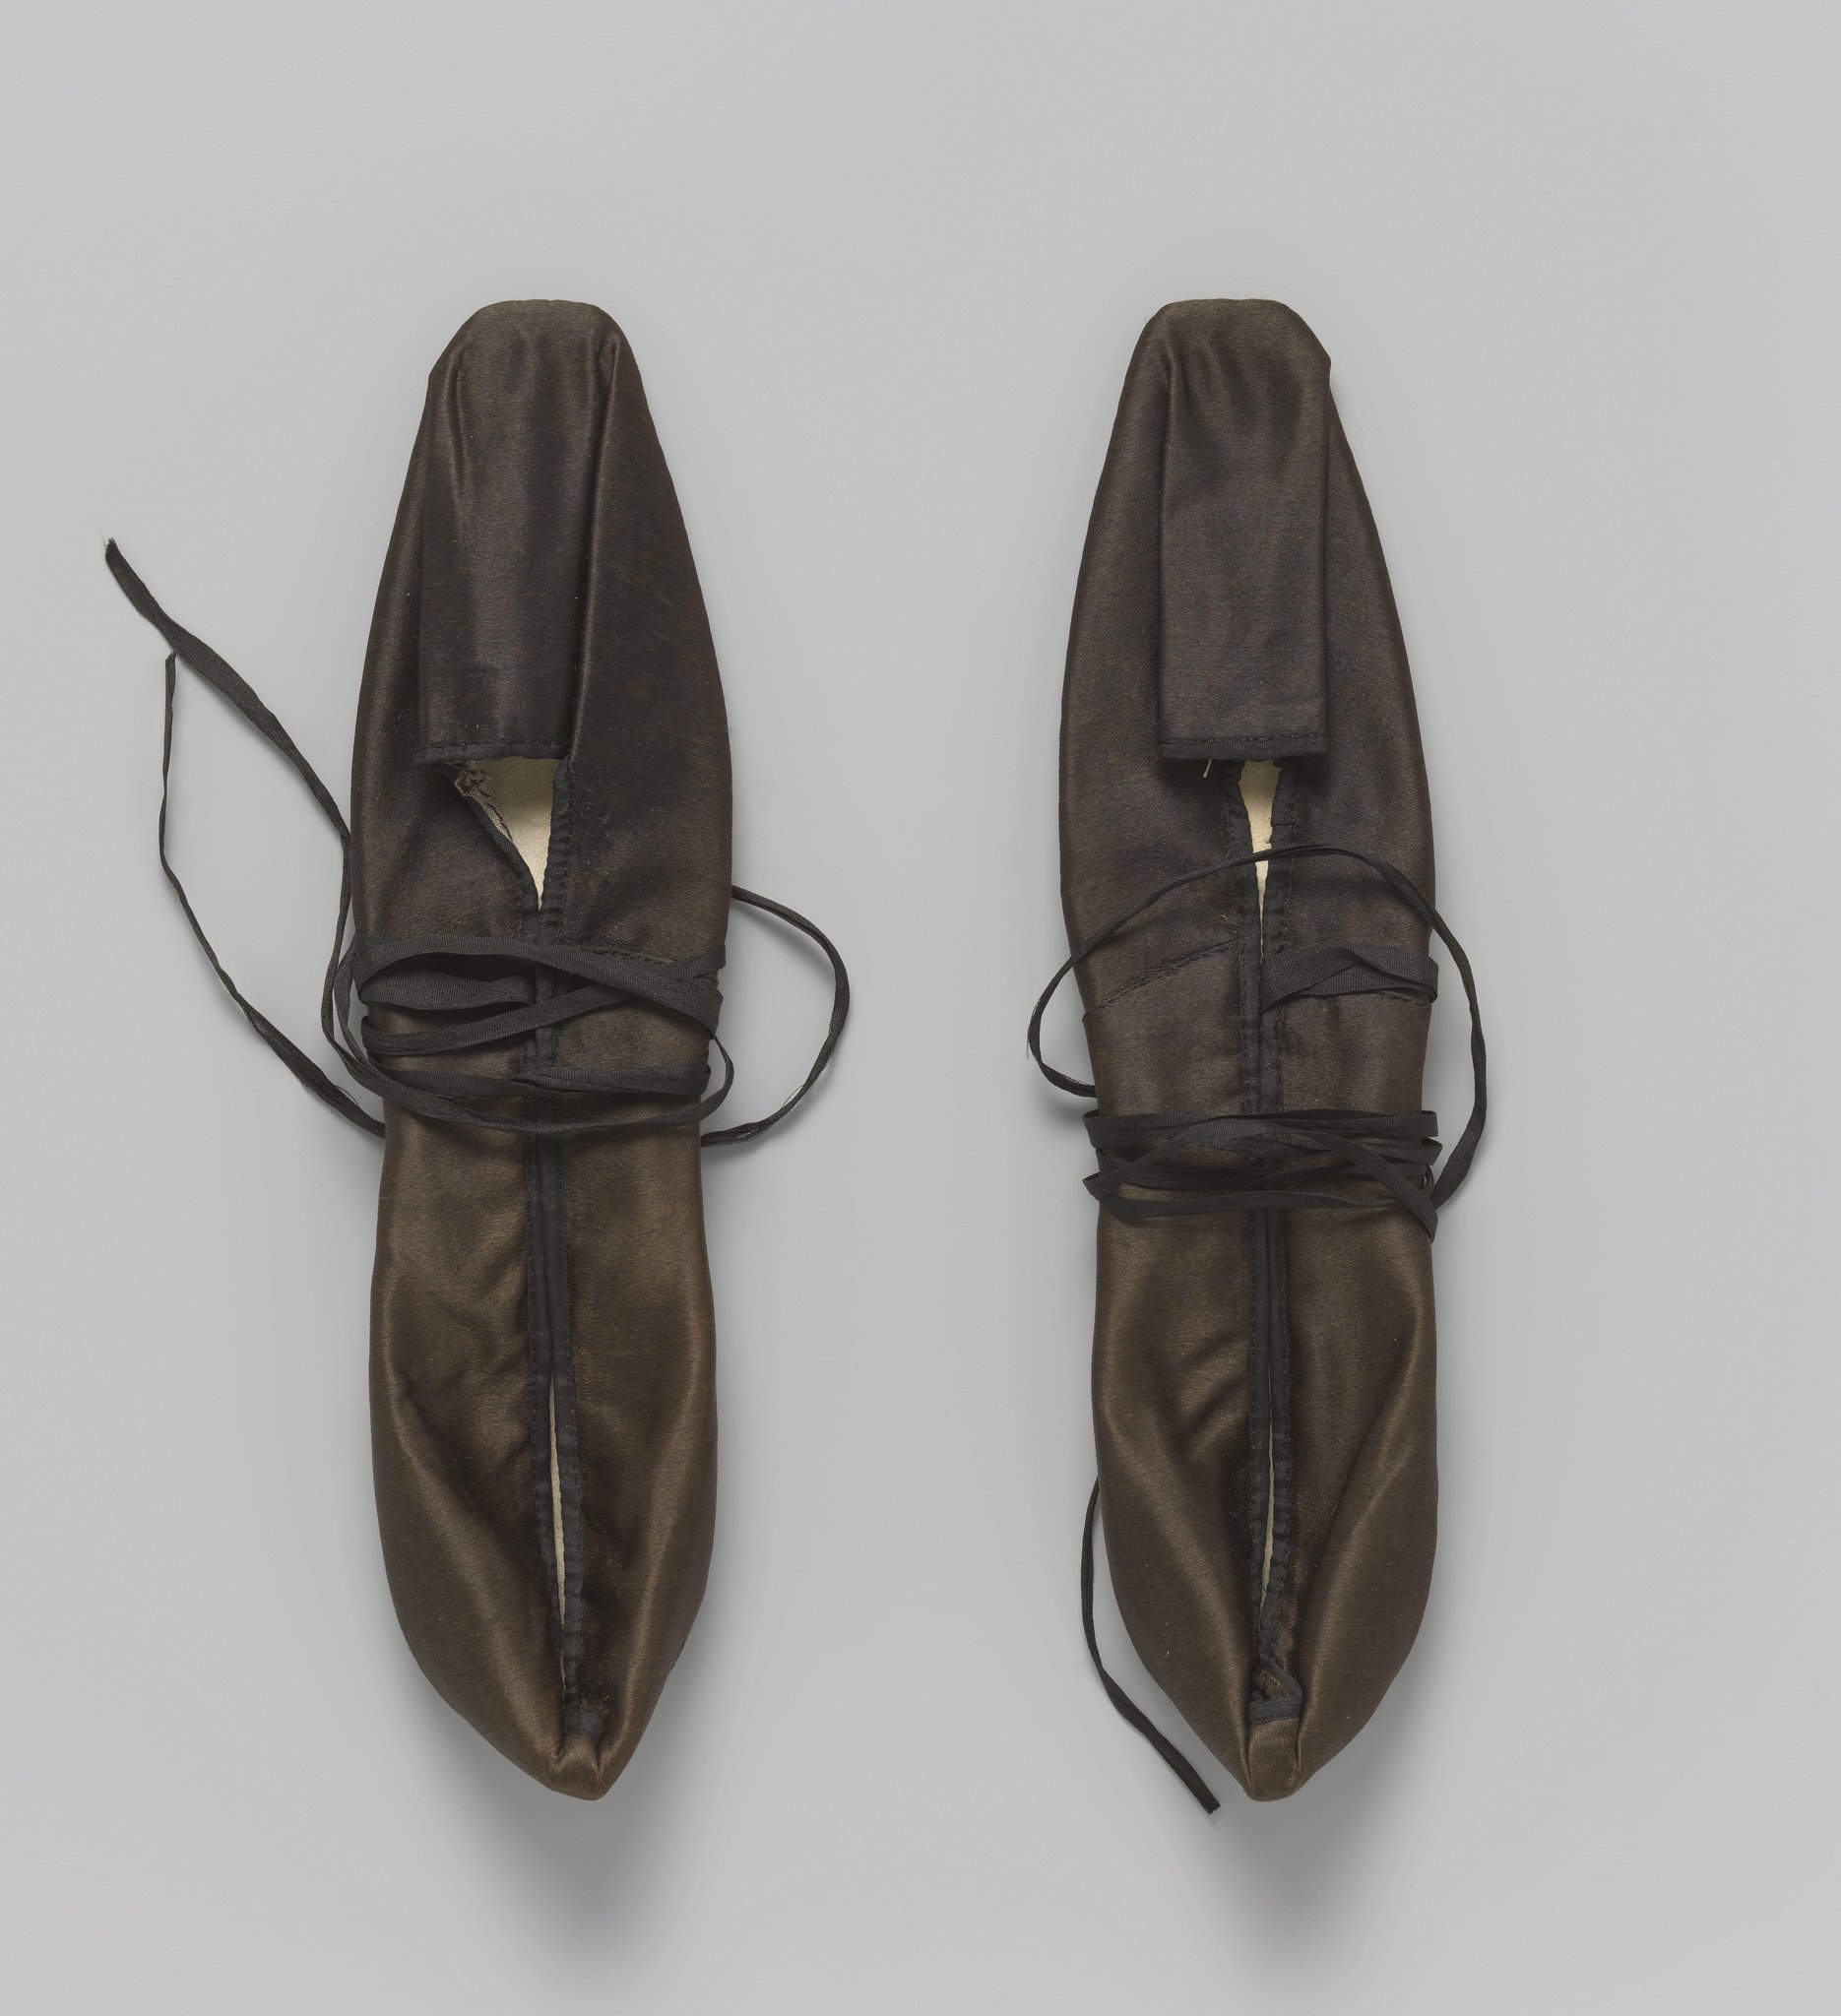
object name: shoe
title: Platte schoen van zwarte zijde met lint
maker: Anonymous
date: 1850-1930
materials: leather, silk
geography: europe